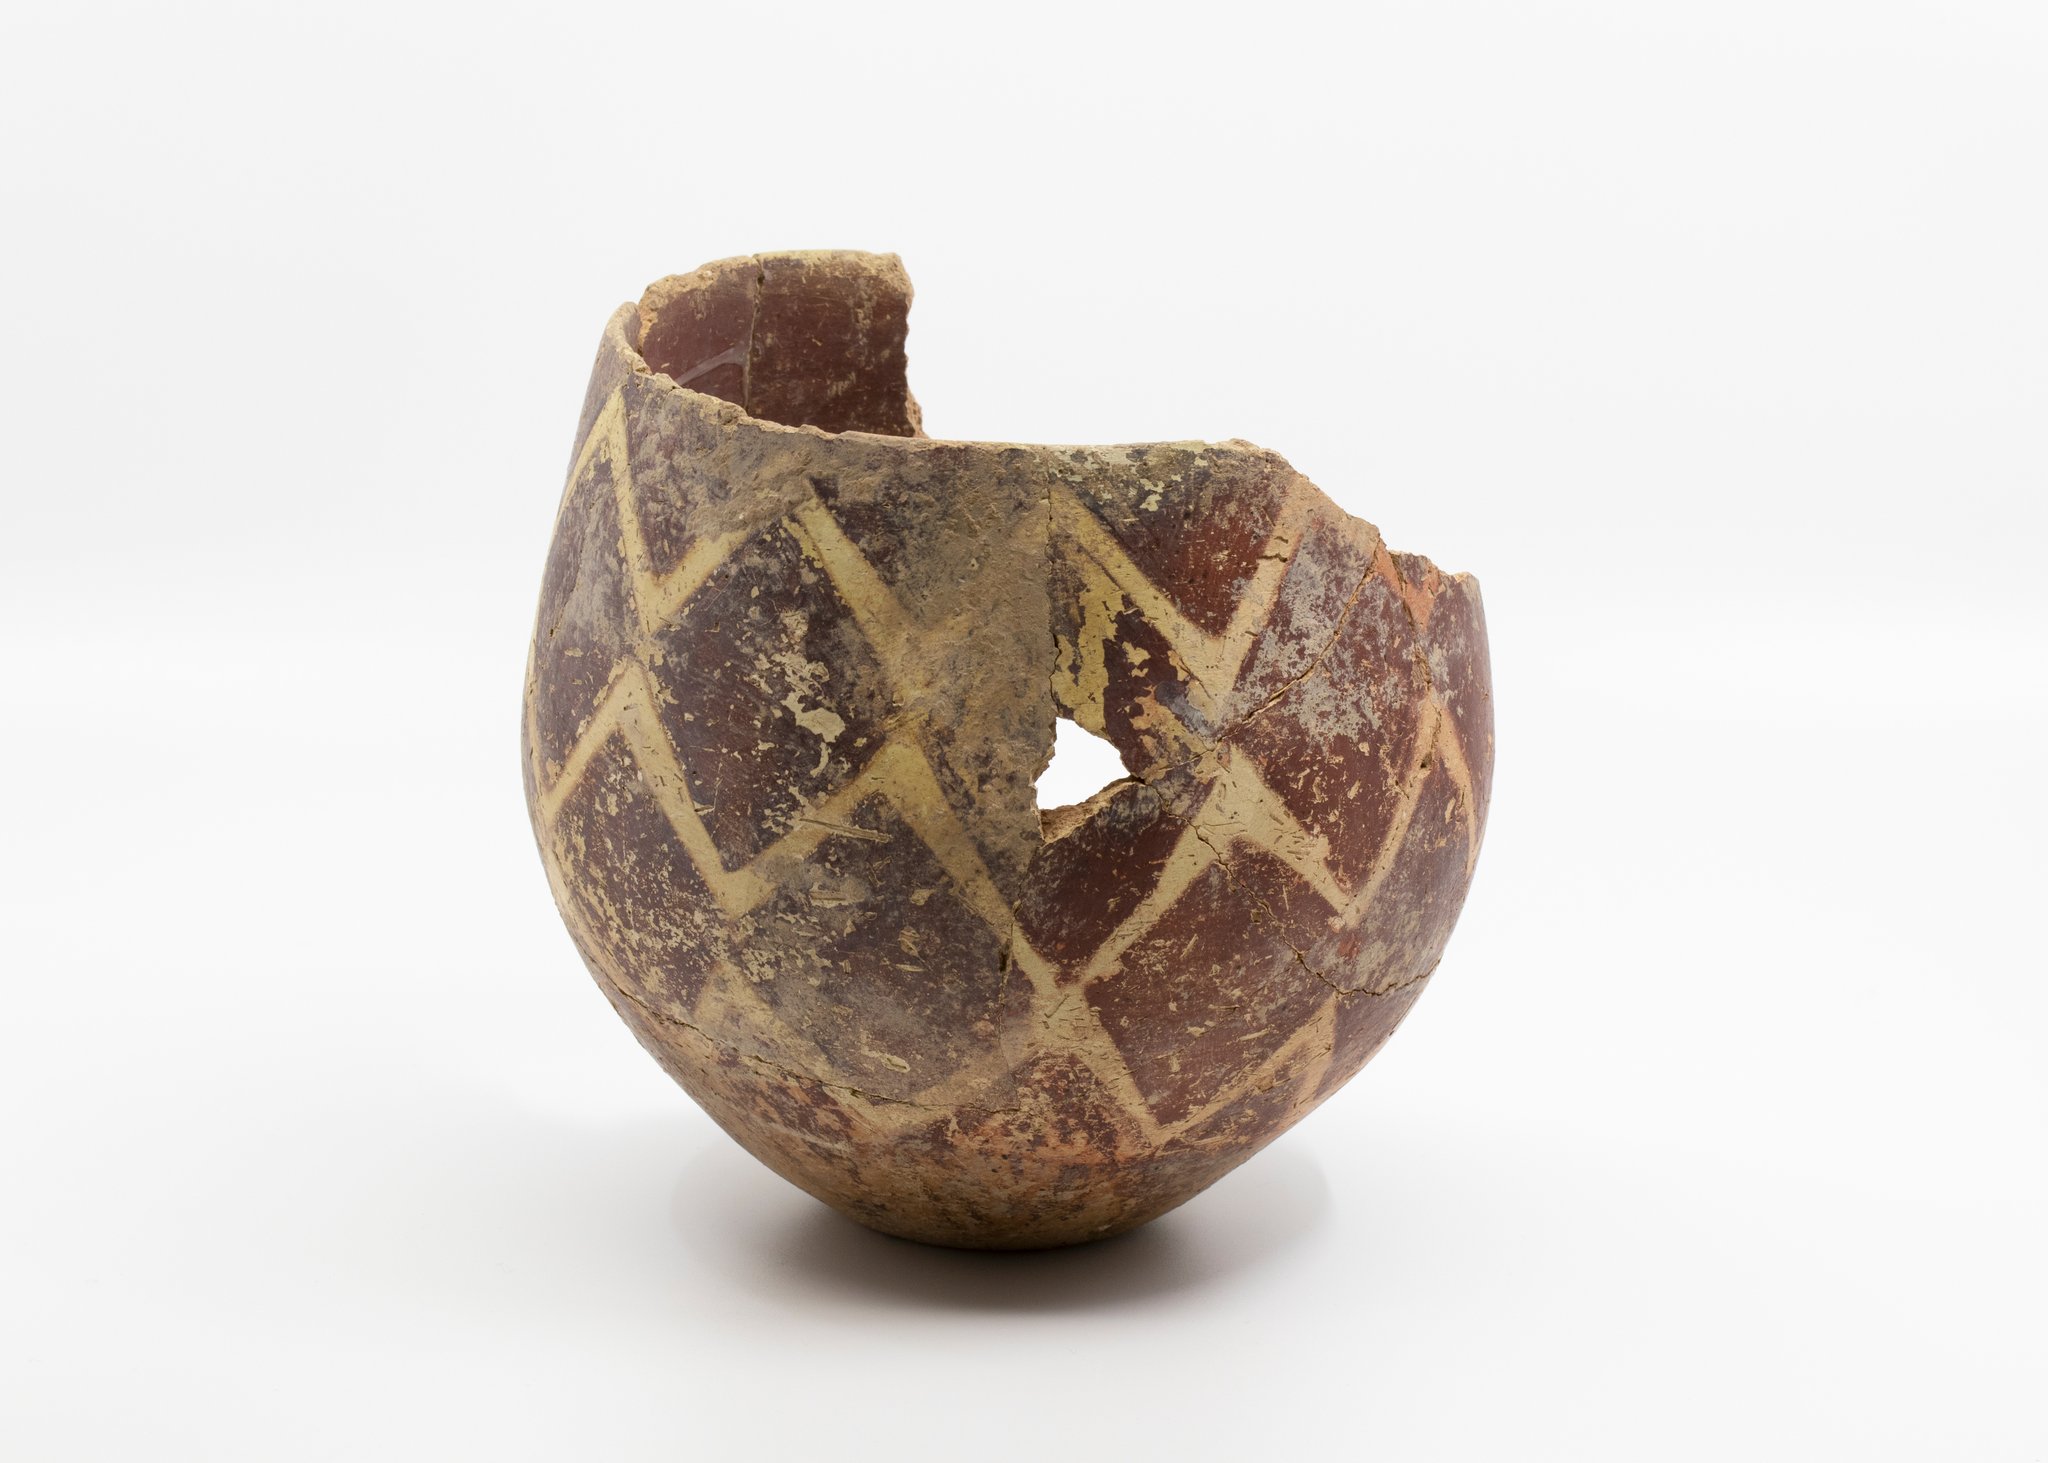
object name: vessel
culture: iranian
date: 5000-4500 BCE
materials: ceramic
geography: iran